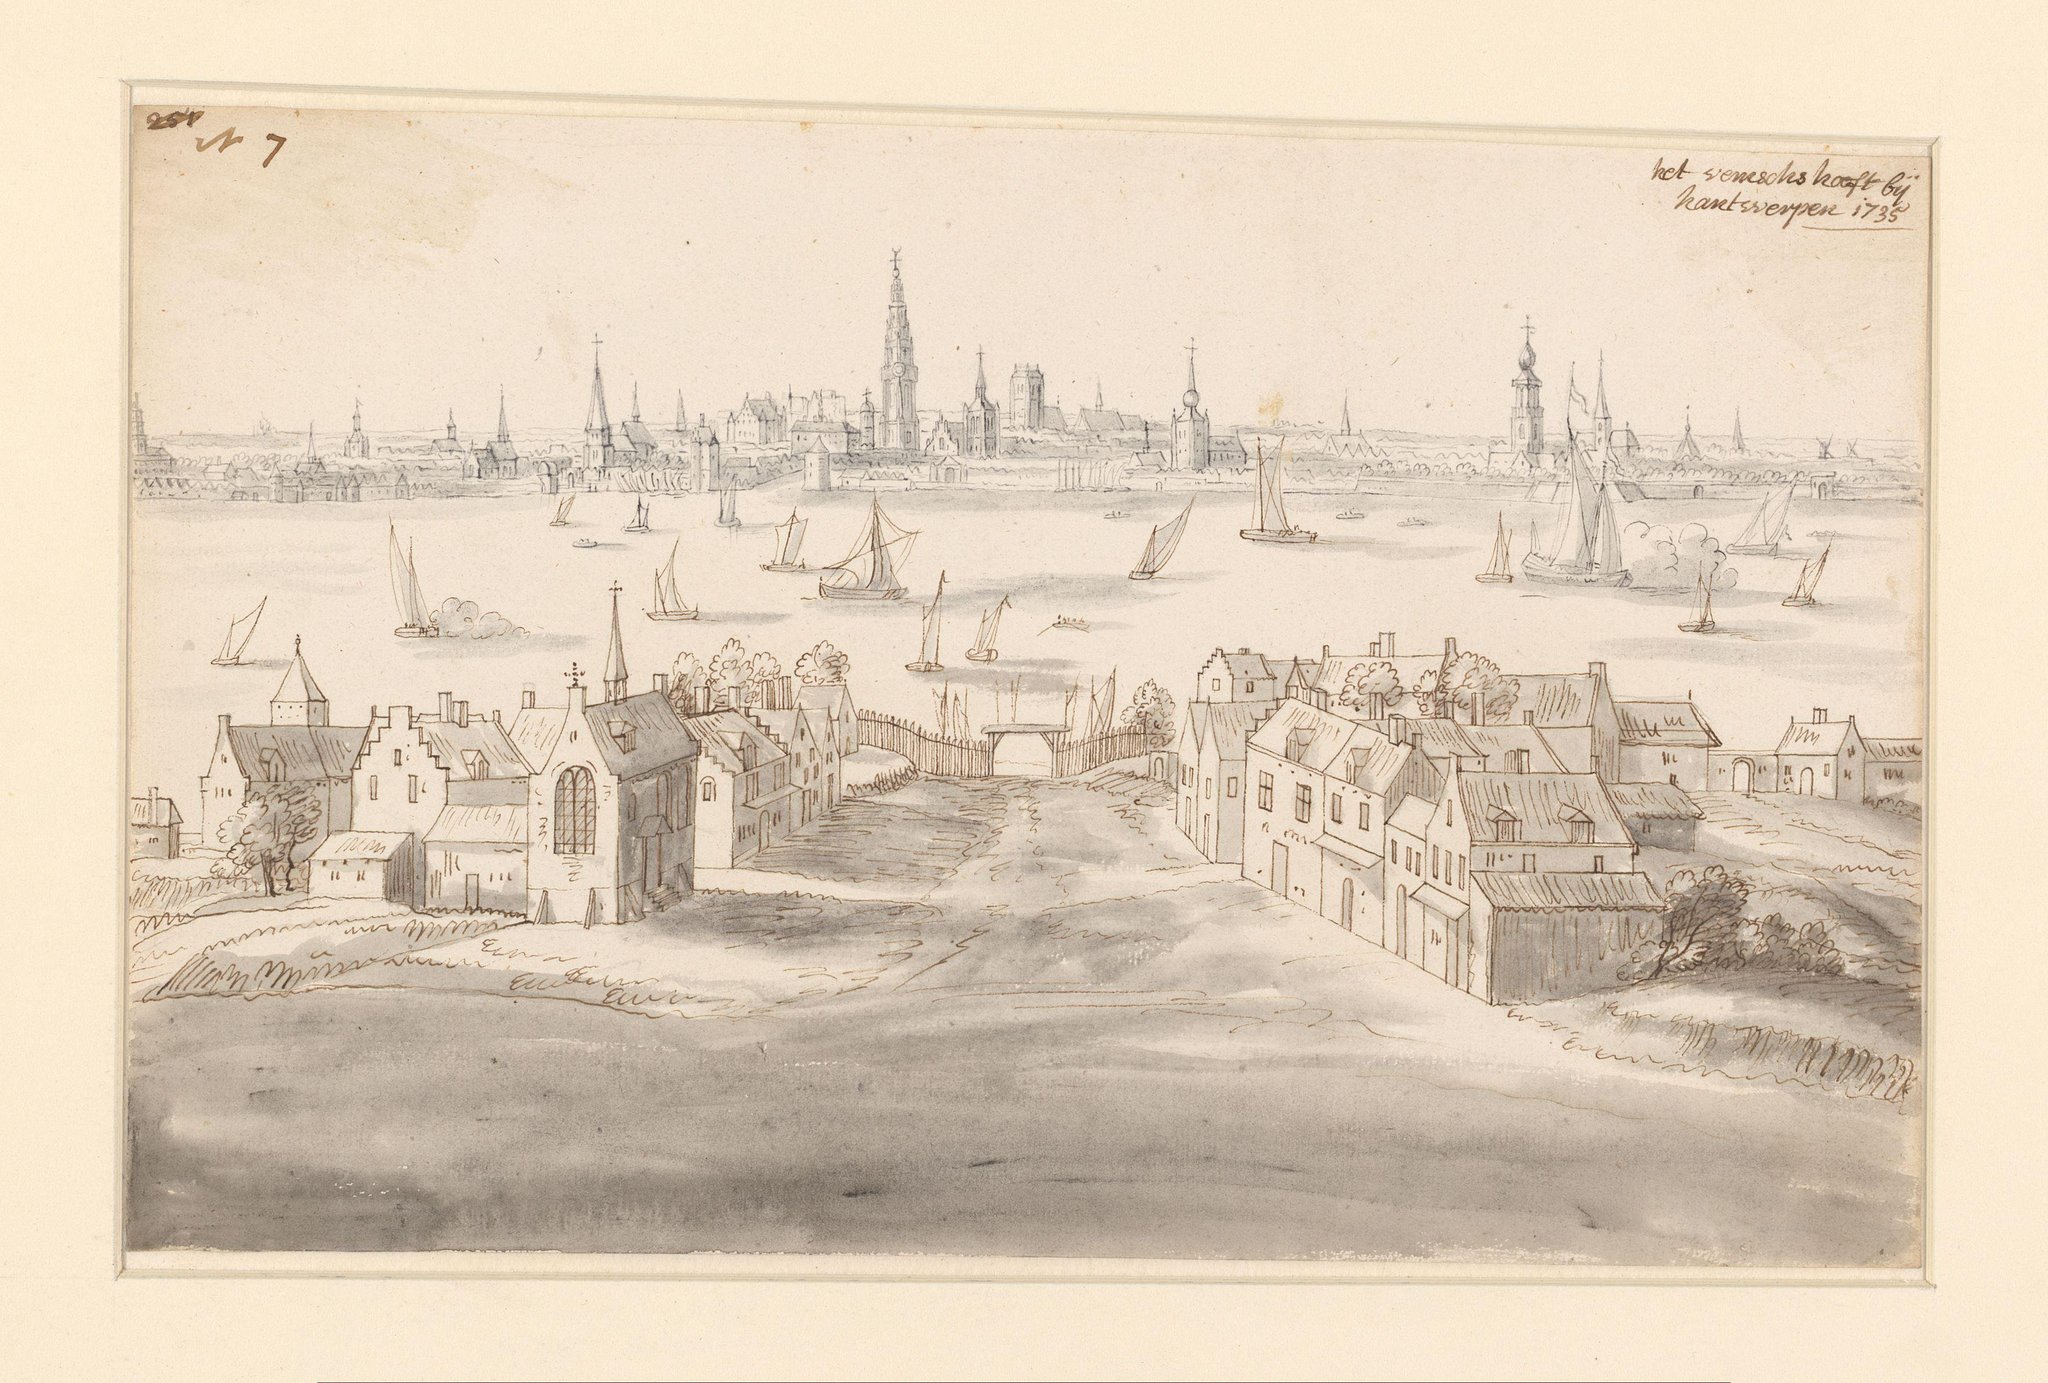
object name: drawing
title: Gezicht op Antwerpen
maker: Anonymous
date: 1735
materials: ink, paper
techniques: brush, pen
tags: city-view, and landscape with man-made constructions, antwerp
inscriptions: date